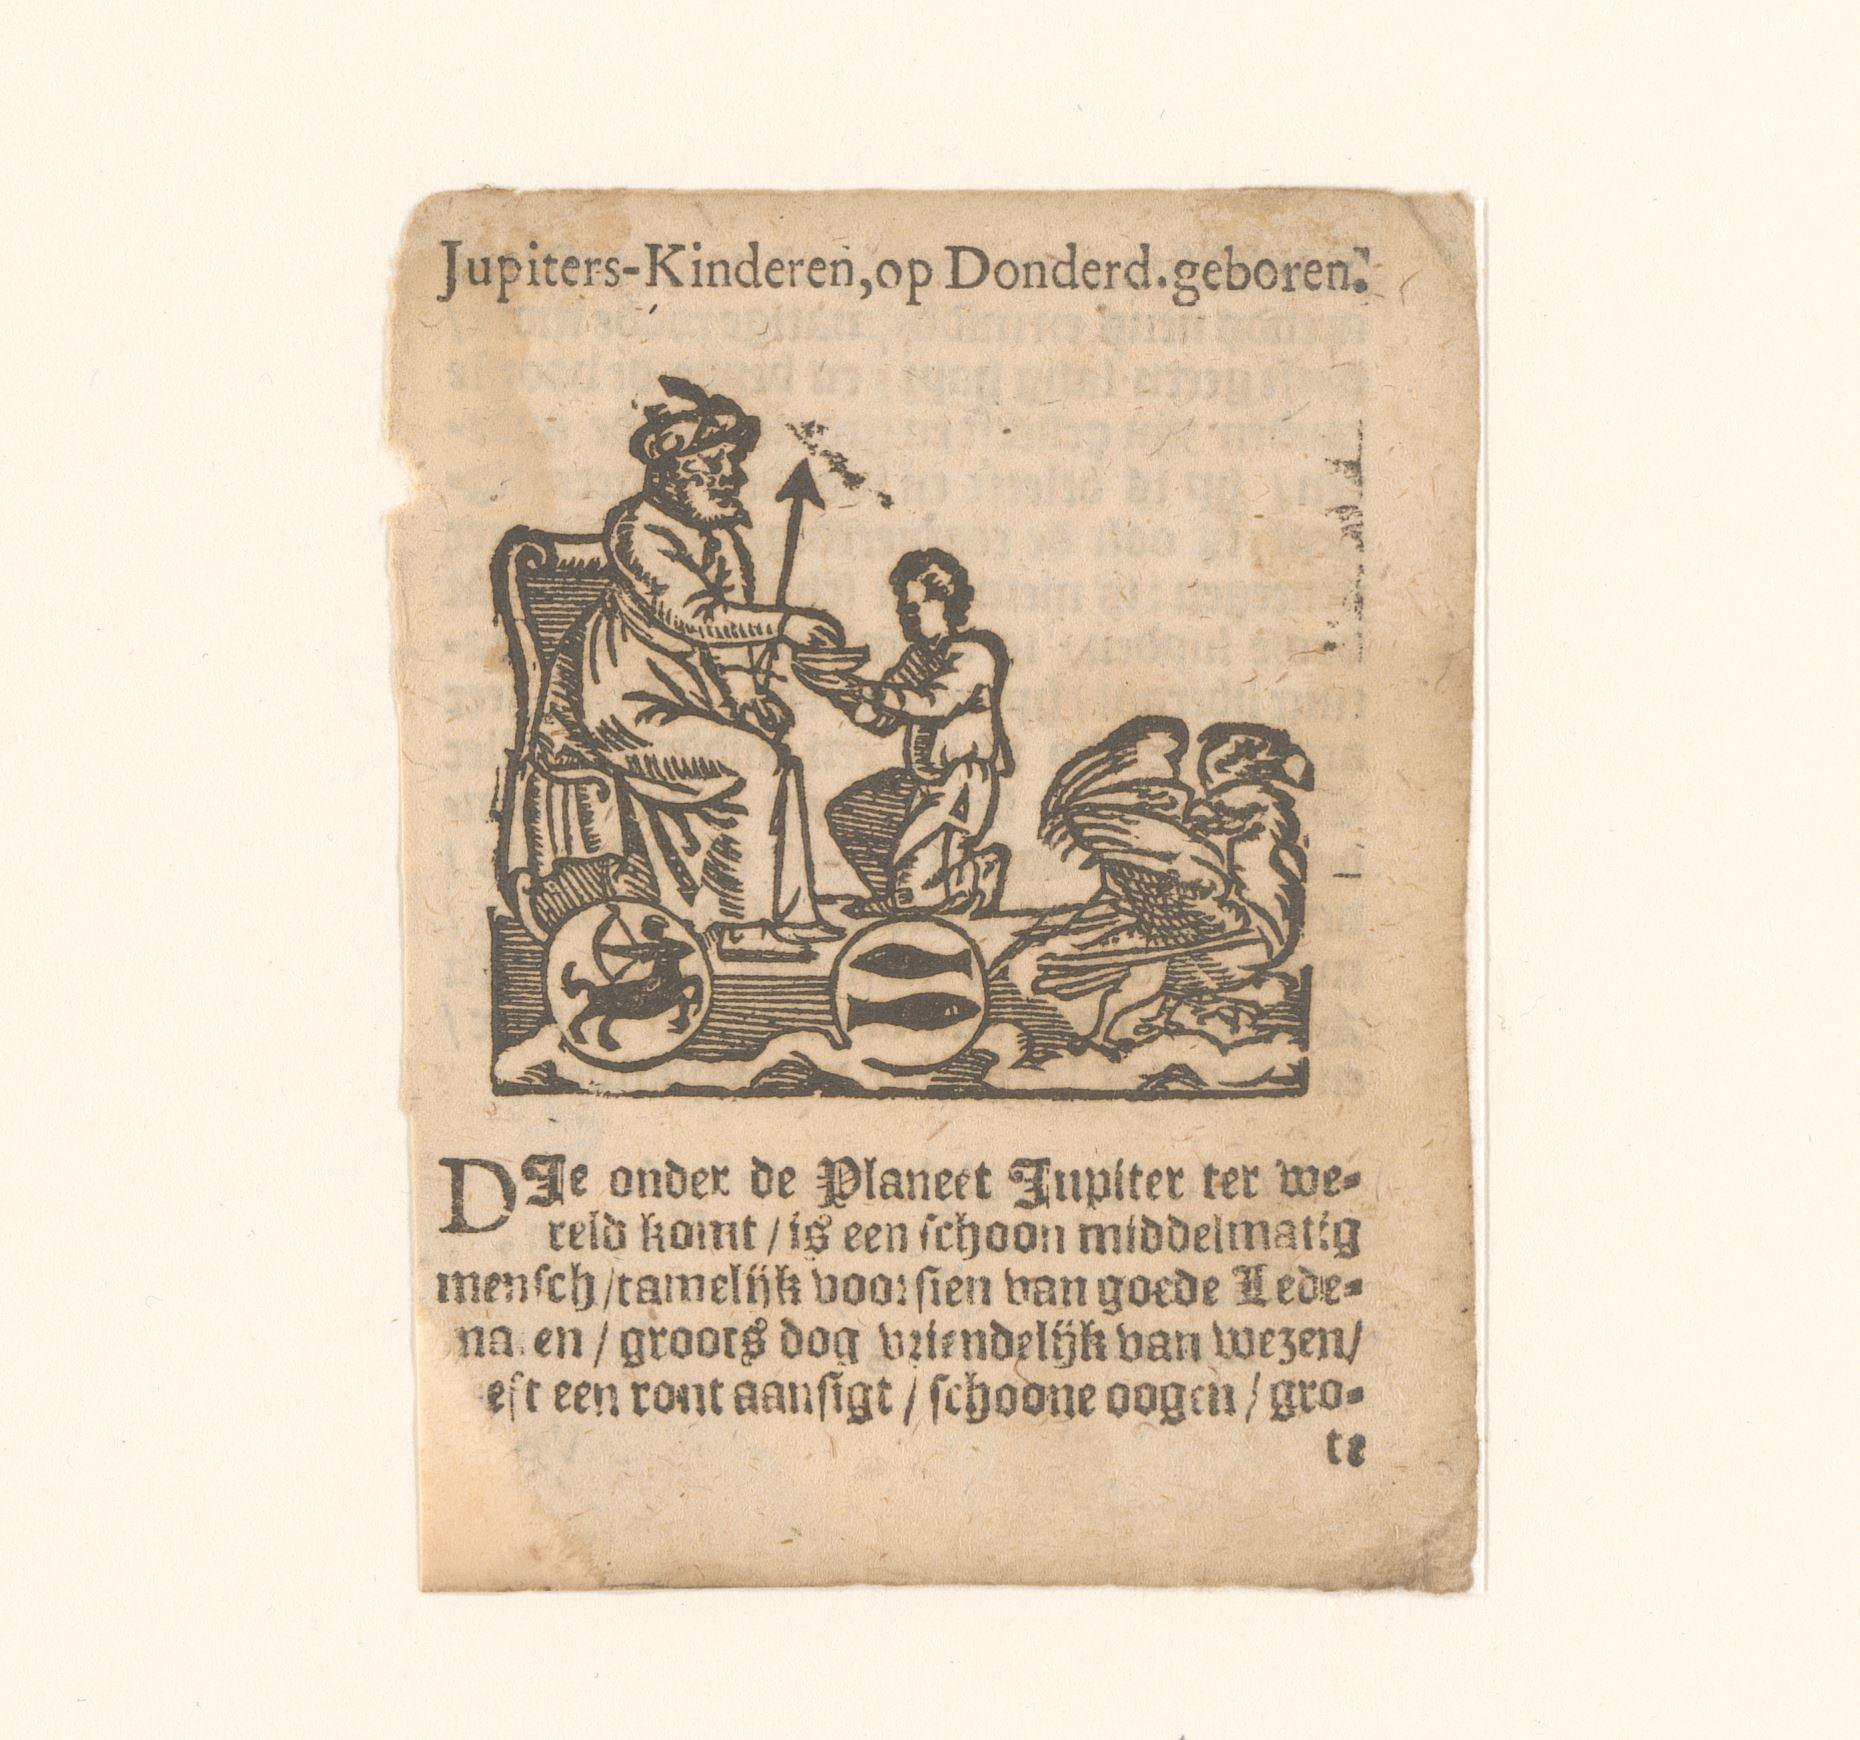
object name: book illustration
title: Jupiter op zegewagen met de sterrenbeelden Boogschutter en Vissen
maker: Anonymous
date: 1500-1599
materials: paper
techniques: letterpress printing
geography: low countries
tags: jupiter and his children ('planetenkinder') ~ pisces and sagittarius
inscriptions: collector's mark: Lugt 2760, collector's mark: Lugt 2228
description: Prent komt uit een onbekende publicatie.